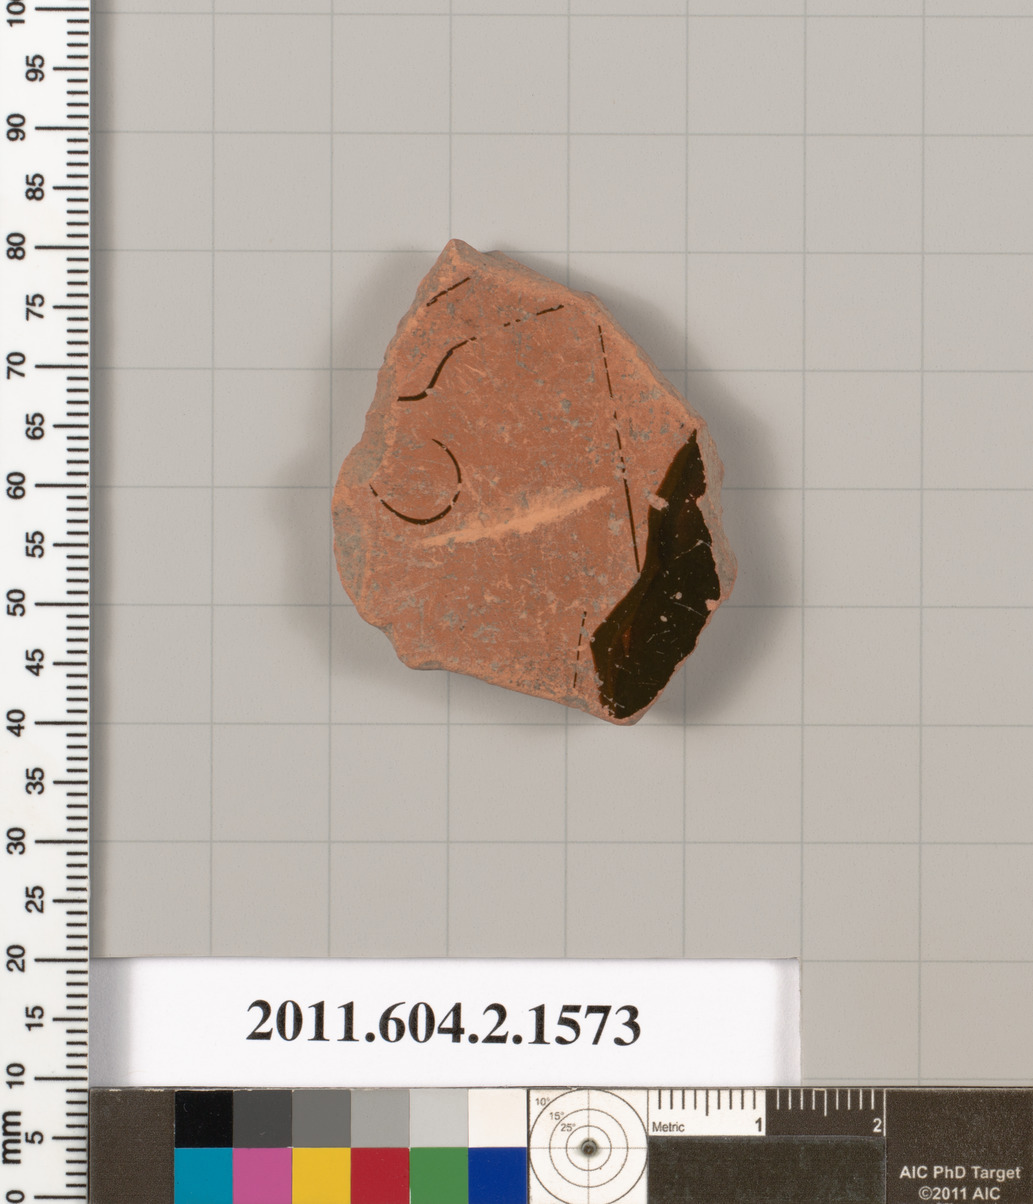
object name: skyphos fragment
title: Terracotta fragment of a skyphos (deep drinking cup)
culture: greek, attic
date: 450-401 BCE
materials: terracotta